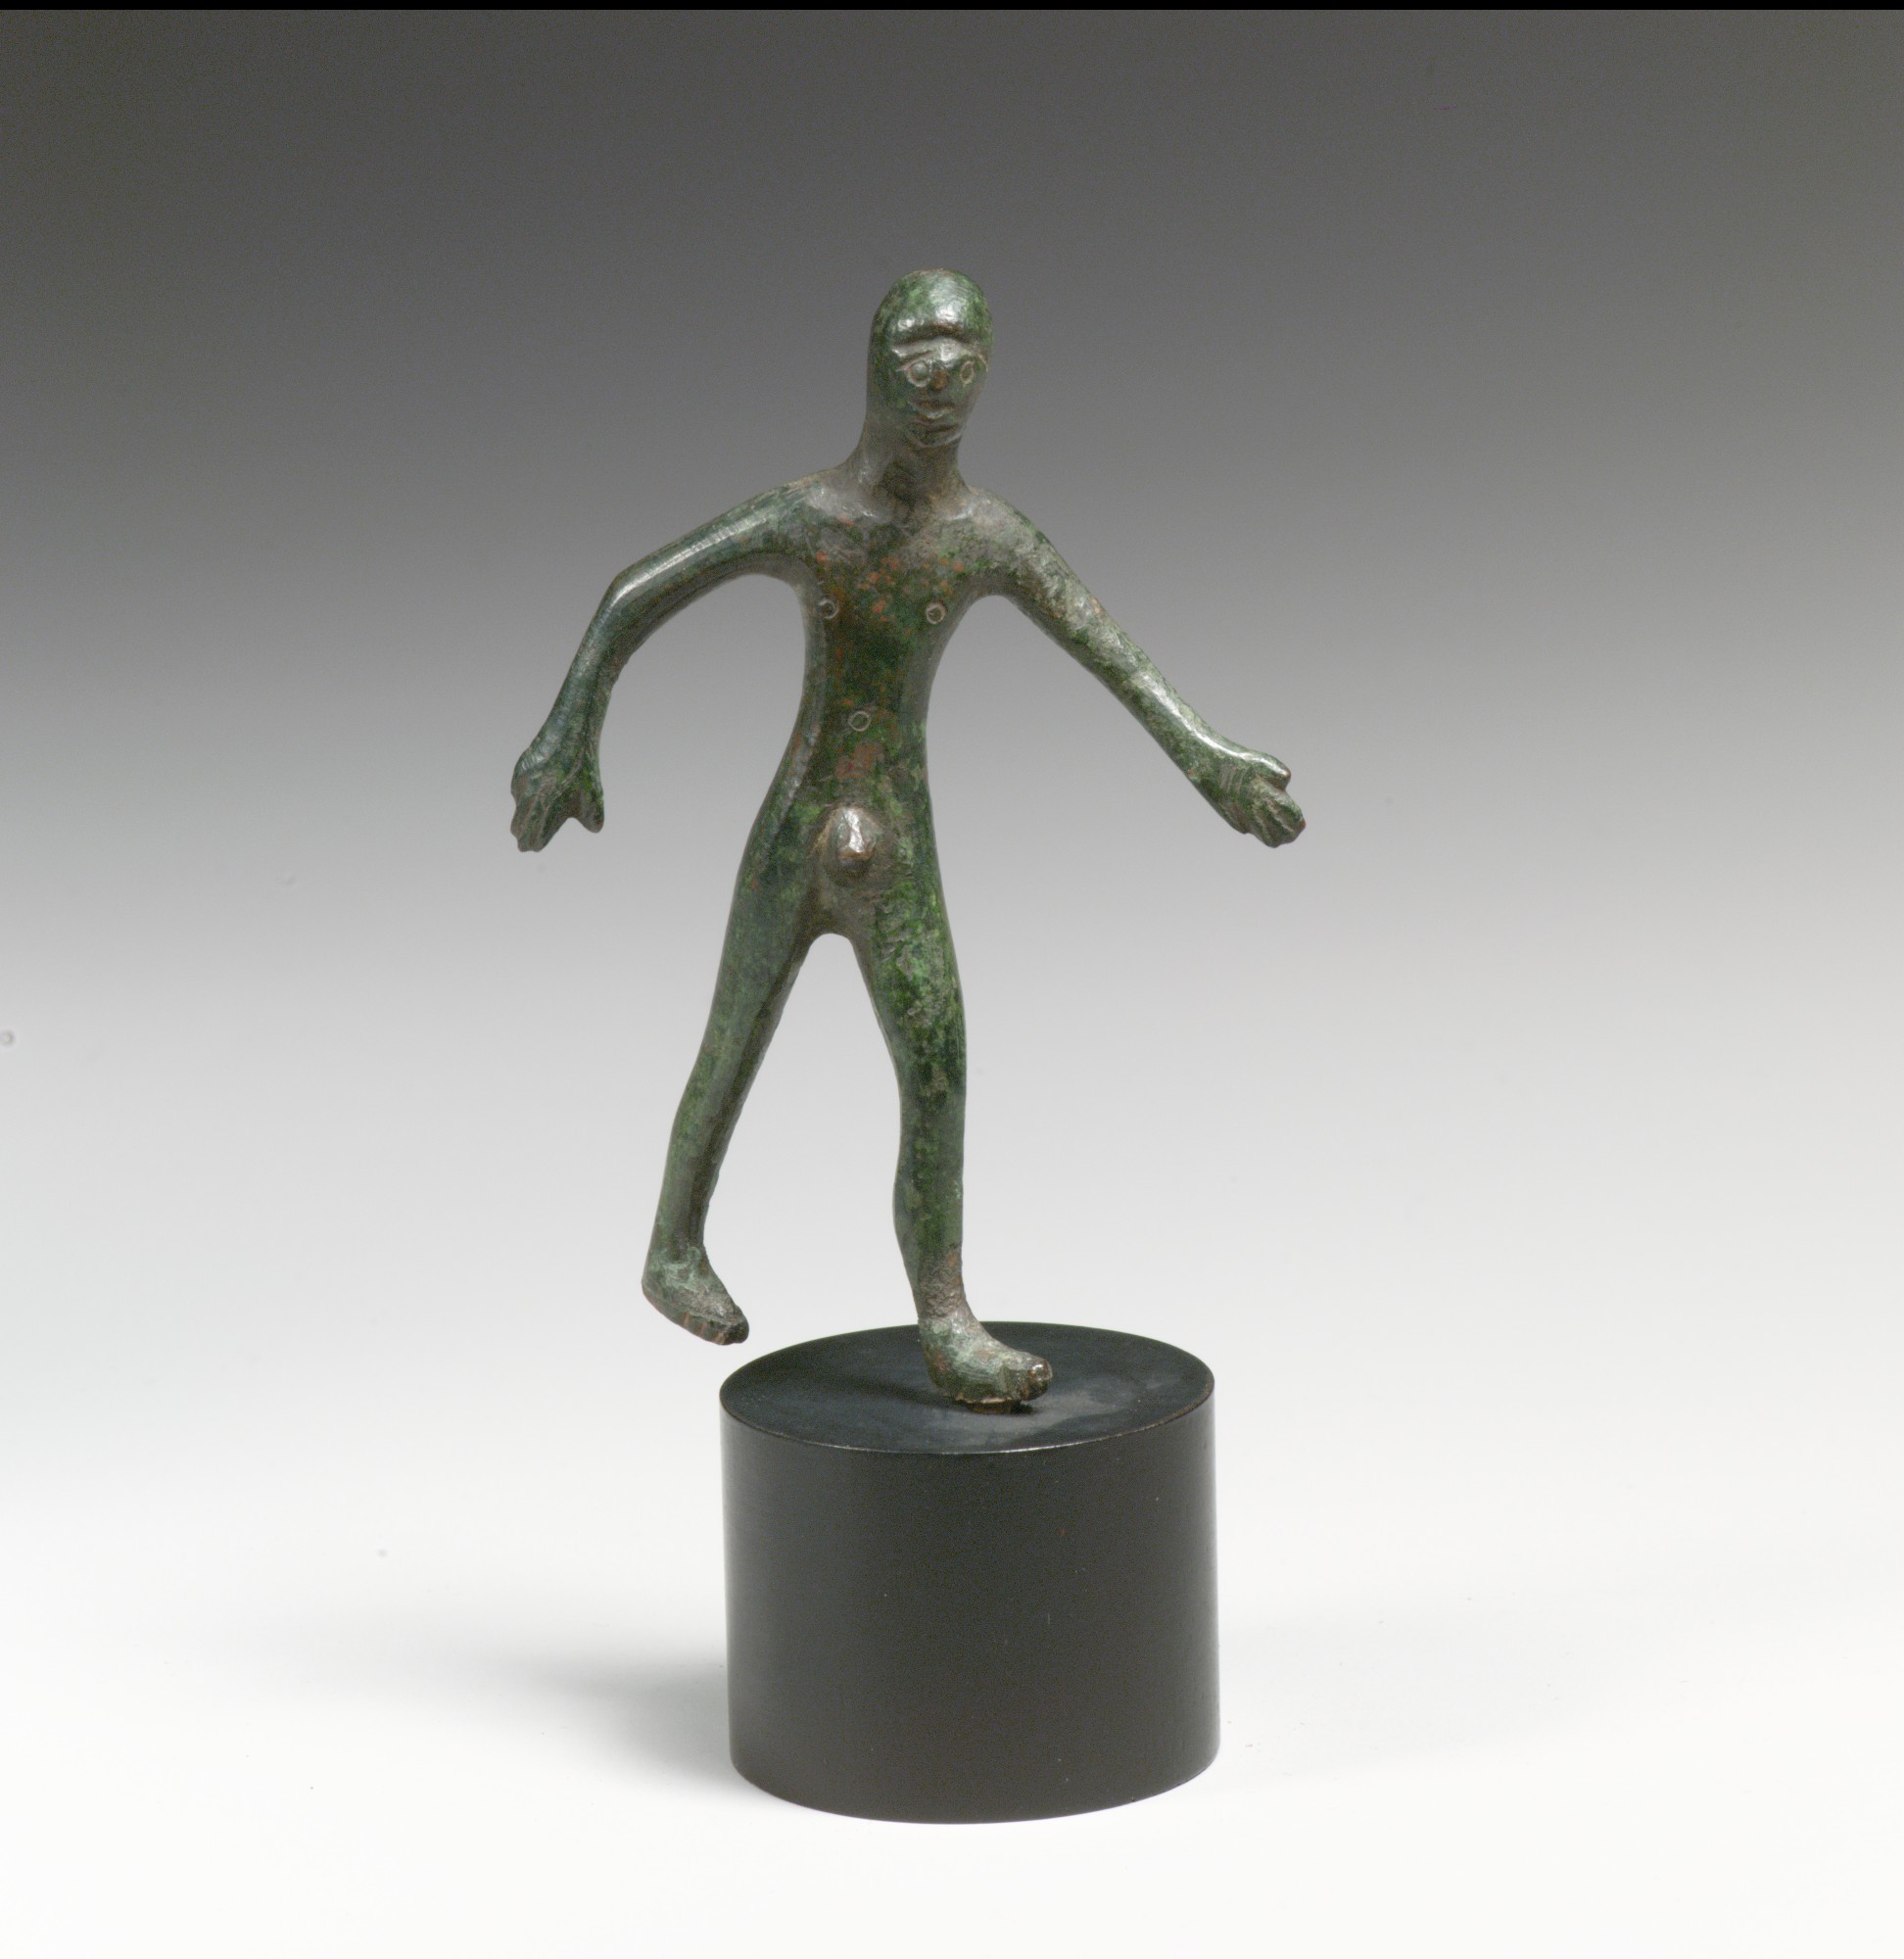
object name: statuette of a youth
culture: italic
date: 600-501 BCE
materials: bronze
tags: male nudes